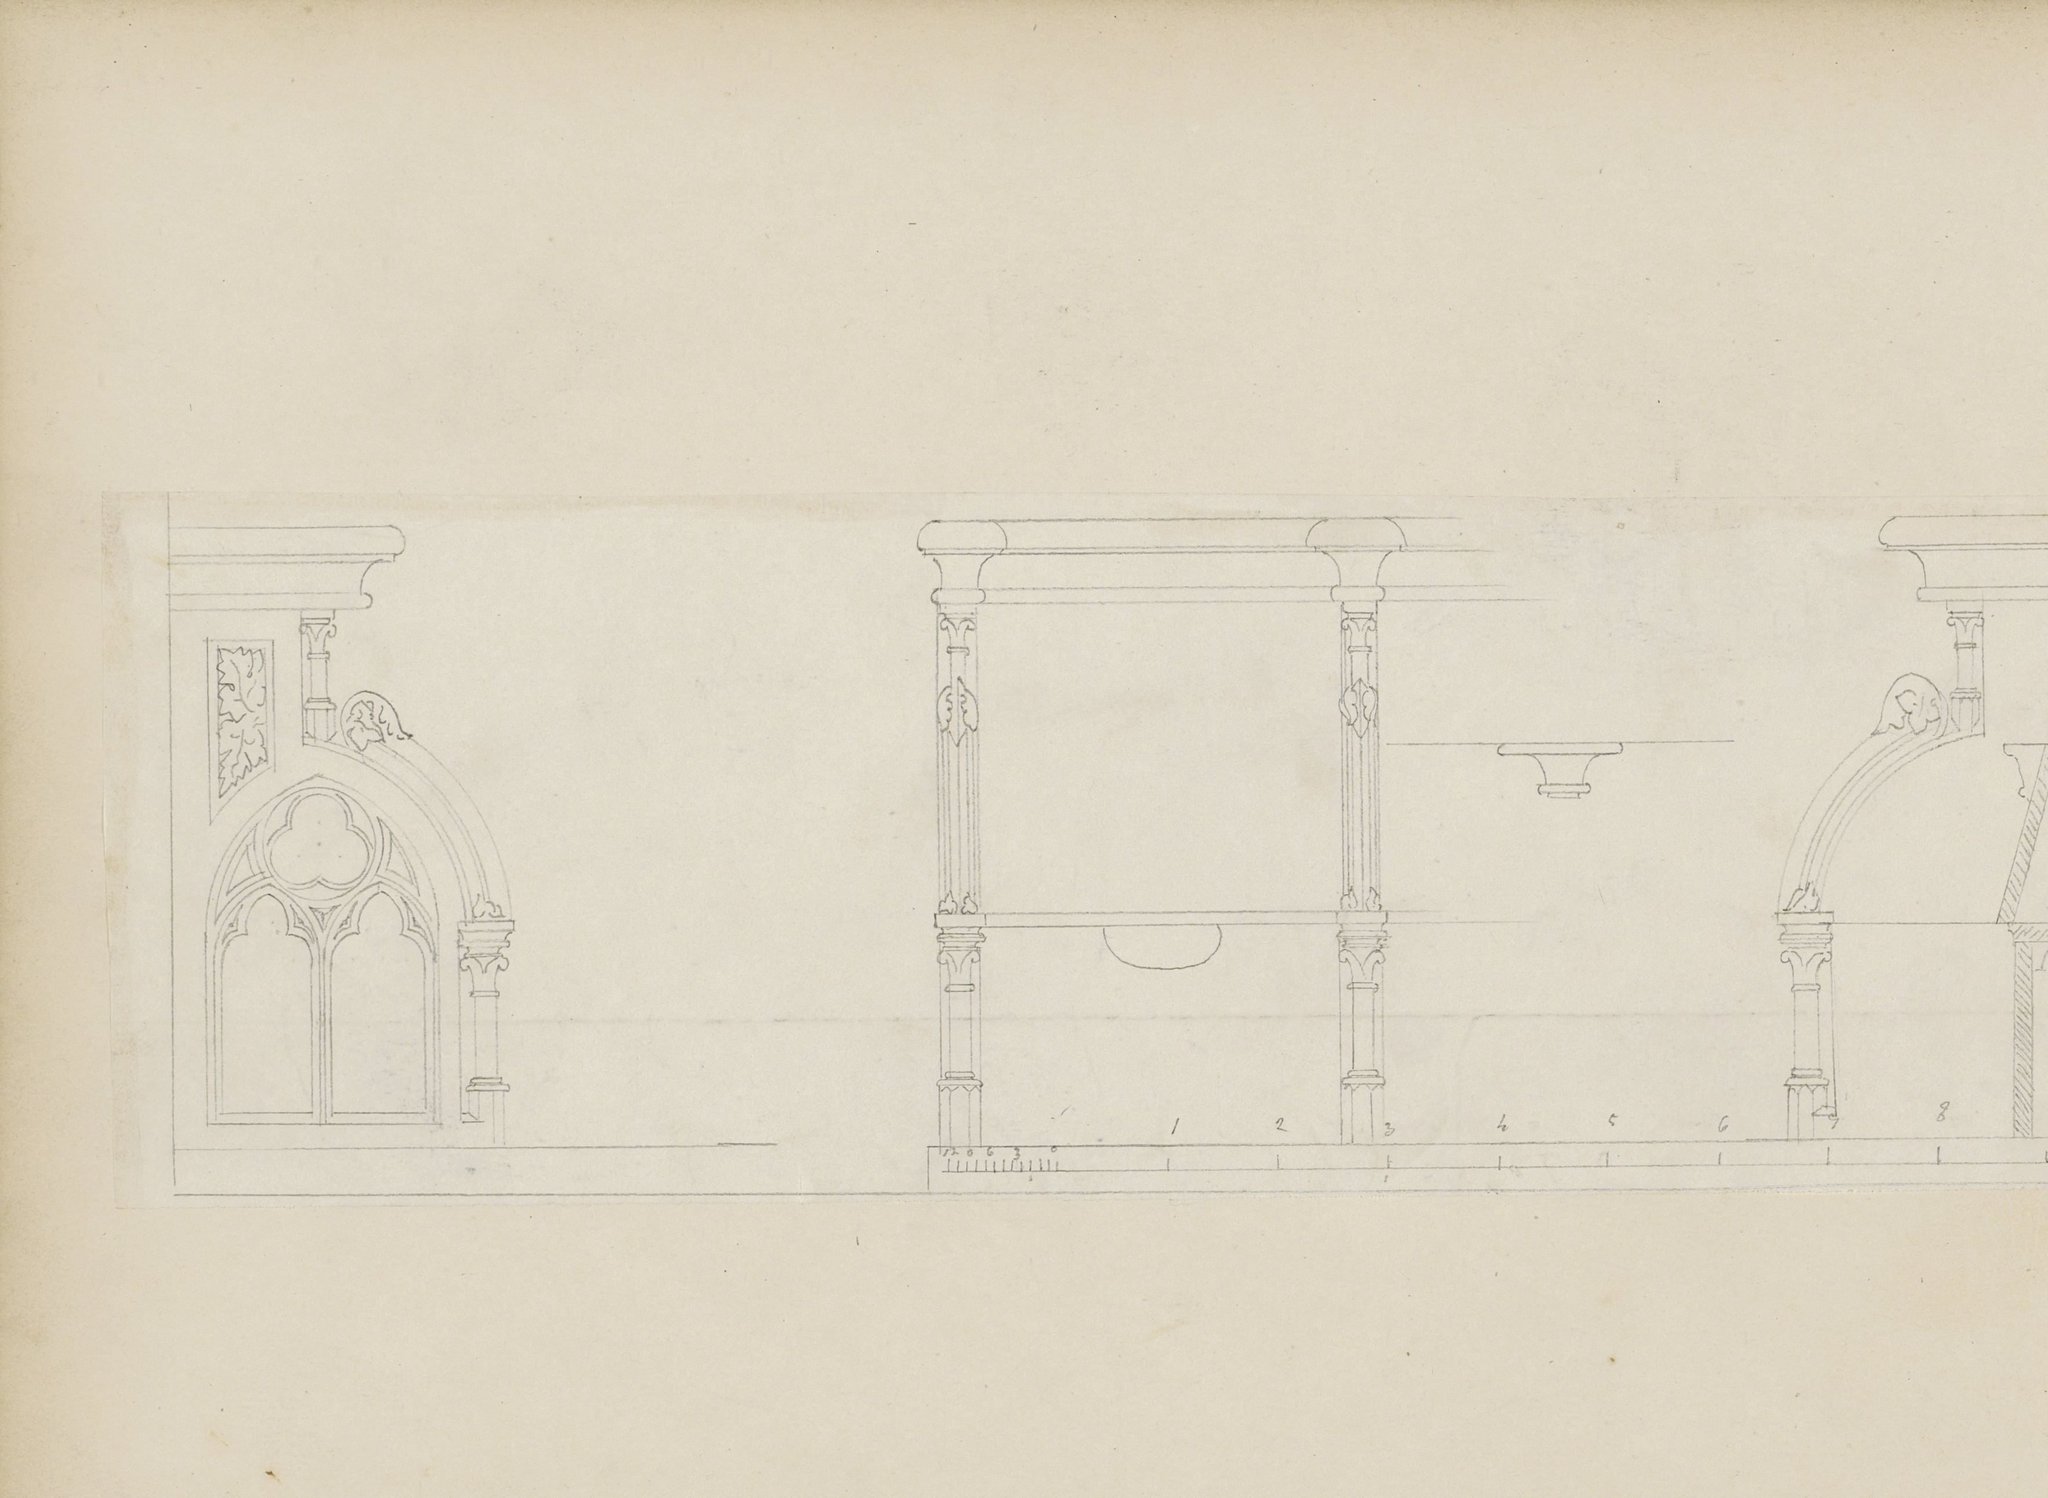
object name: sketchbook leaf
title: Studieblad, onder andere met een kerkraam en zuilen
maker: pierre joseph hubert cuypers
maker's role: draughtsman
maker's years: 1827-1921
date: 1857-1859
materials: paper, pencil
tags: column, pillar ~ architecture, church-window, e.g. rose-window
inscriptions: annotation: ‘[...]’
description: Blad 68 verso uit een schetsboek met 77 bladen.